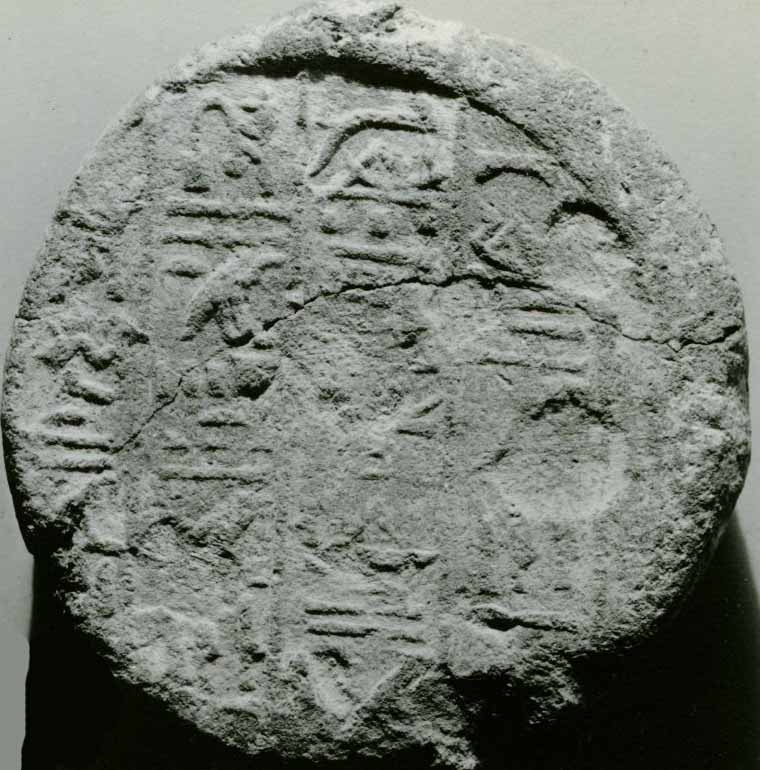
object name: cone, nenay, circular impression, overseer, barque, scribe, army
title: Funerary Cone of the Overseer of the Barque Tannay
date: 1550-1295 BCE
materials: pottery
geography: egypt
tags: hieroglyphs